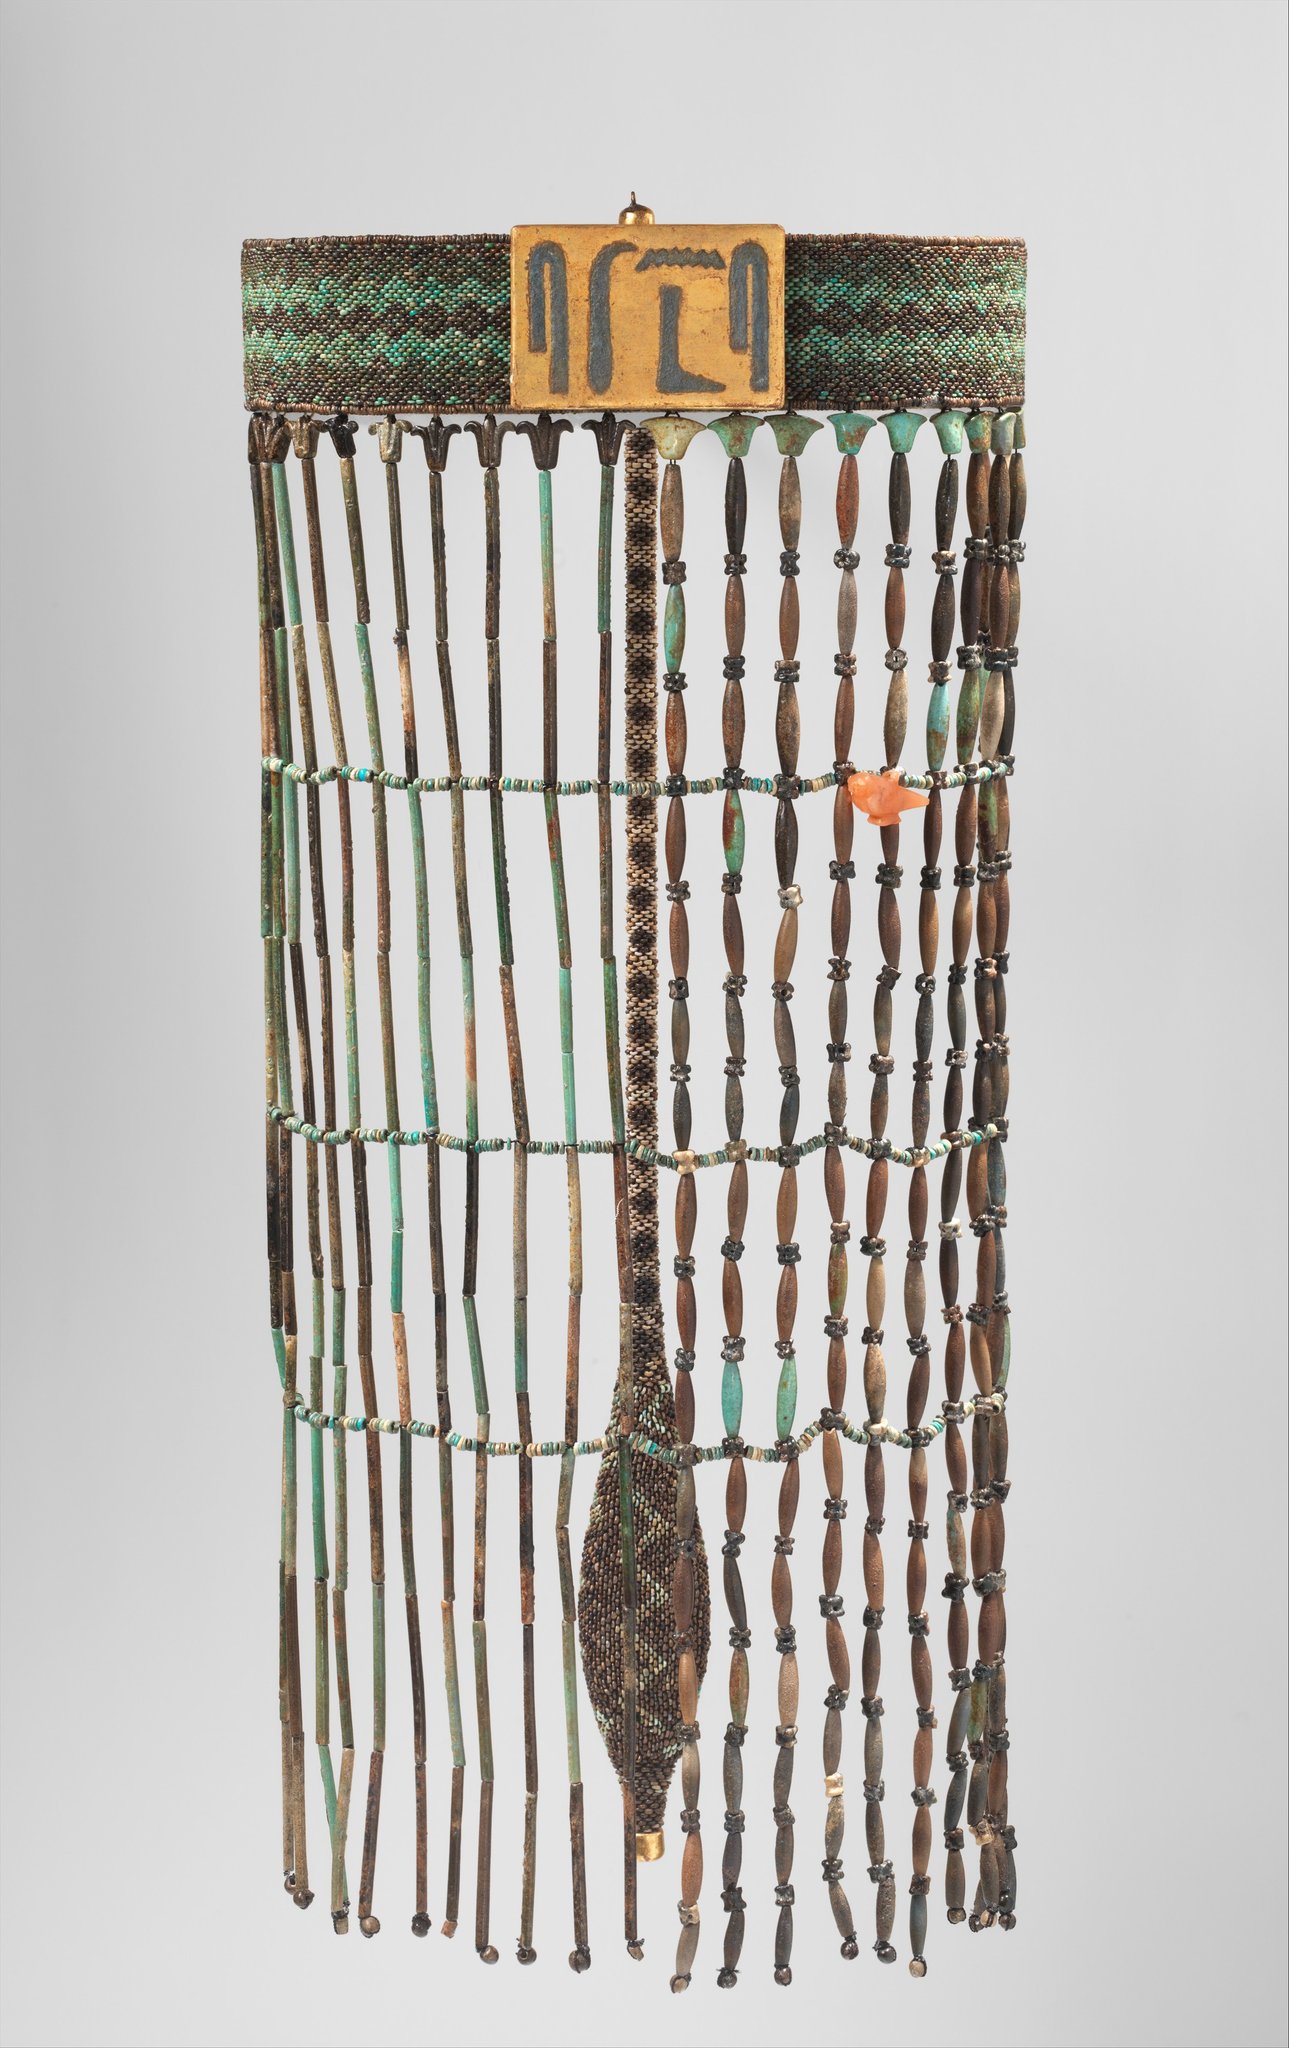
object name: apron, beadwork, senebtisi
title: Beadwork apron of Senebtisi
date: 1850-1775 BCE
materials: faience, paint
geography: egypt